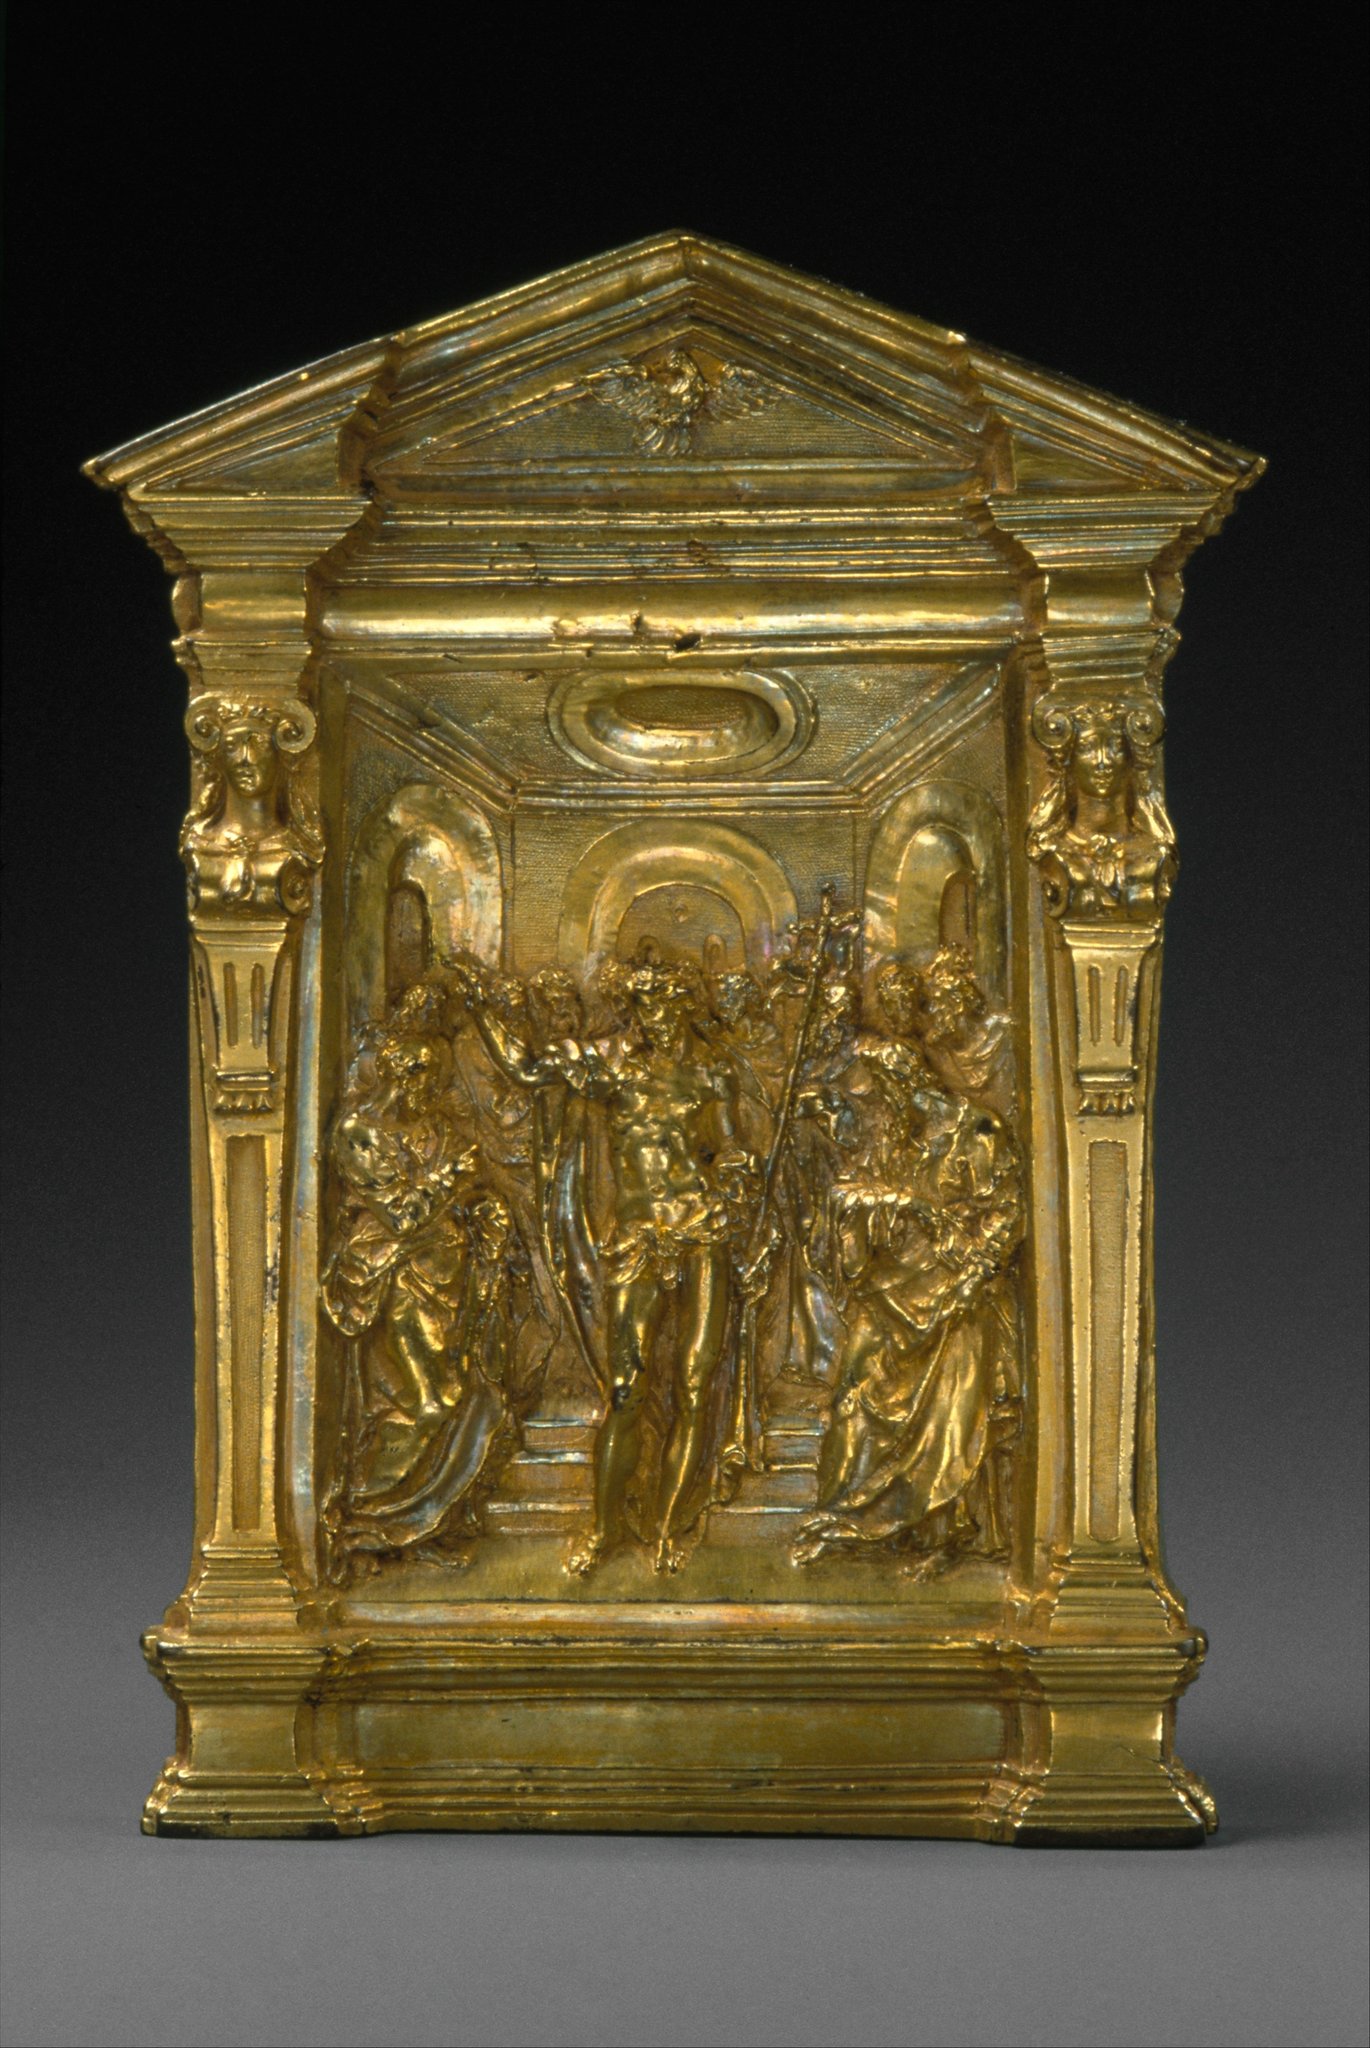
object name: plaque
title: Pax with the Risen Christ Appearing to the Apostles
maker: guglielmo della porta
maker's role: artist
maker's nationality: italian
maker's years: 1500-1577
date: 1566-1577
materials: gilt bronze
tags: apostles,christ